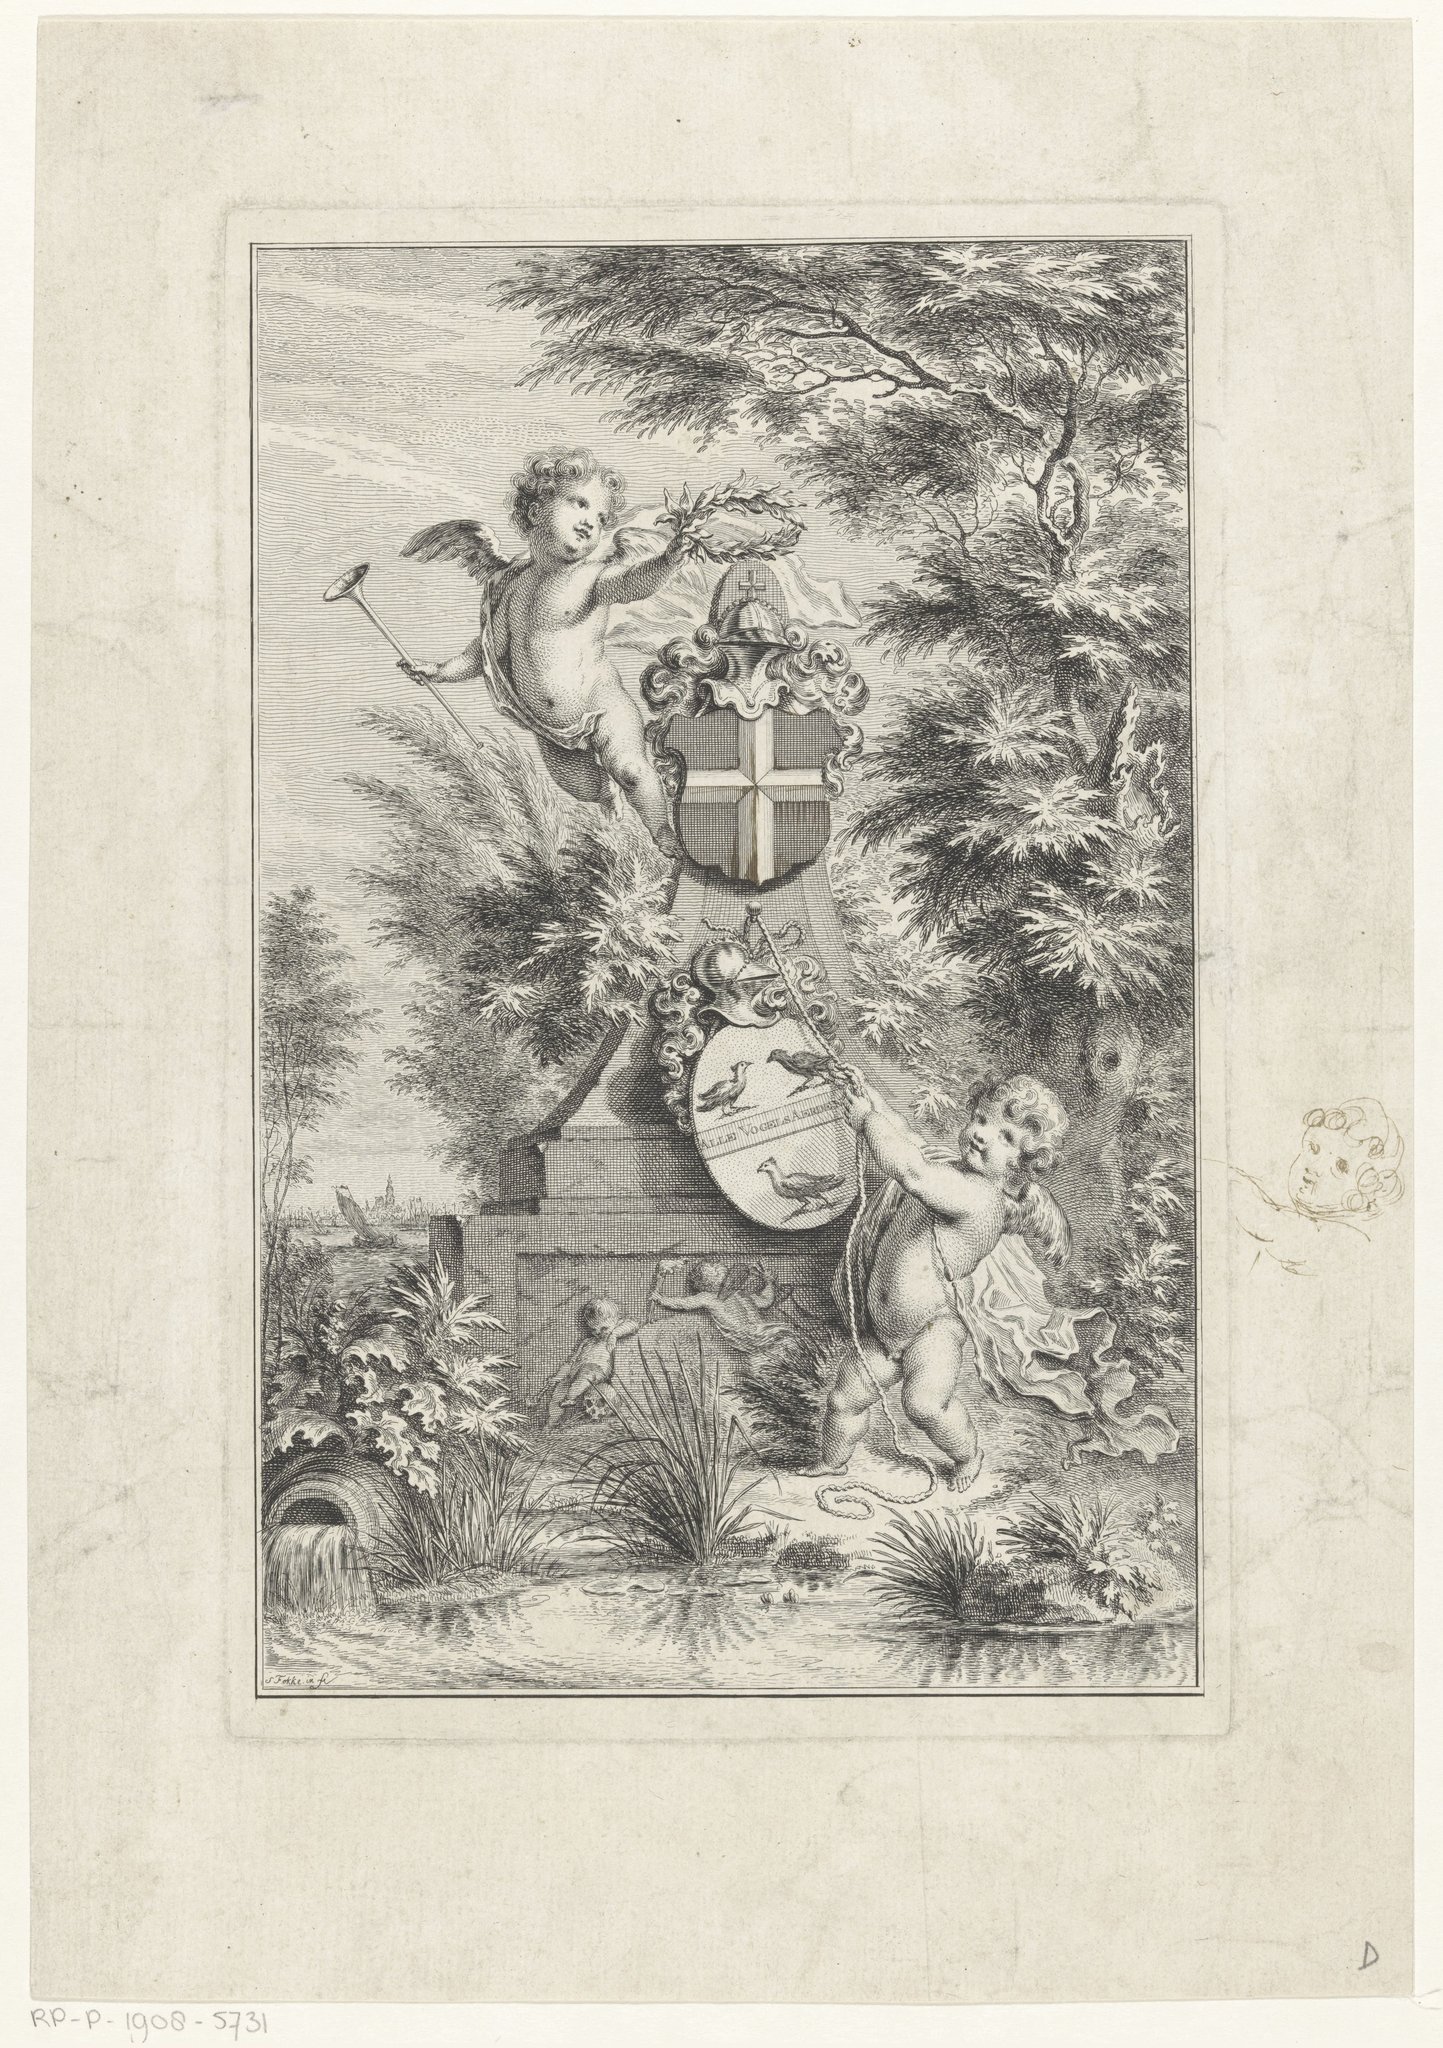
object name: print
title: Allegorisch gedenkteken met gehelmde familiewapens Pelt en Vogels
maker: simon fokke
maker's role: draughtsman, print maker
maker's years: 1712-1784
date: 1755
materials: paper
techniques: etching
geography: amsterdam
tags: other memorial structures, cupids: 'amores', 'amoretti', 'putti'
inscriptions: inscription: ‘J.C C.L. Brinkman / De Heeren J. van Reynsnoek Boekh. te Rotterdam’, collector's mark: Lugt 2228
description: Twee putti bij een gedenkteken. De vliegende putto met bazuin in de hand lauwert het wapenschild met kruis op de top. De tweede putto hijst met een touw een wapen met drie vogels en het devies "alle vogels aerden" op het gedenkteken. In de achtergrond een gezicht op een stad aan het water.